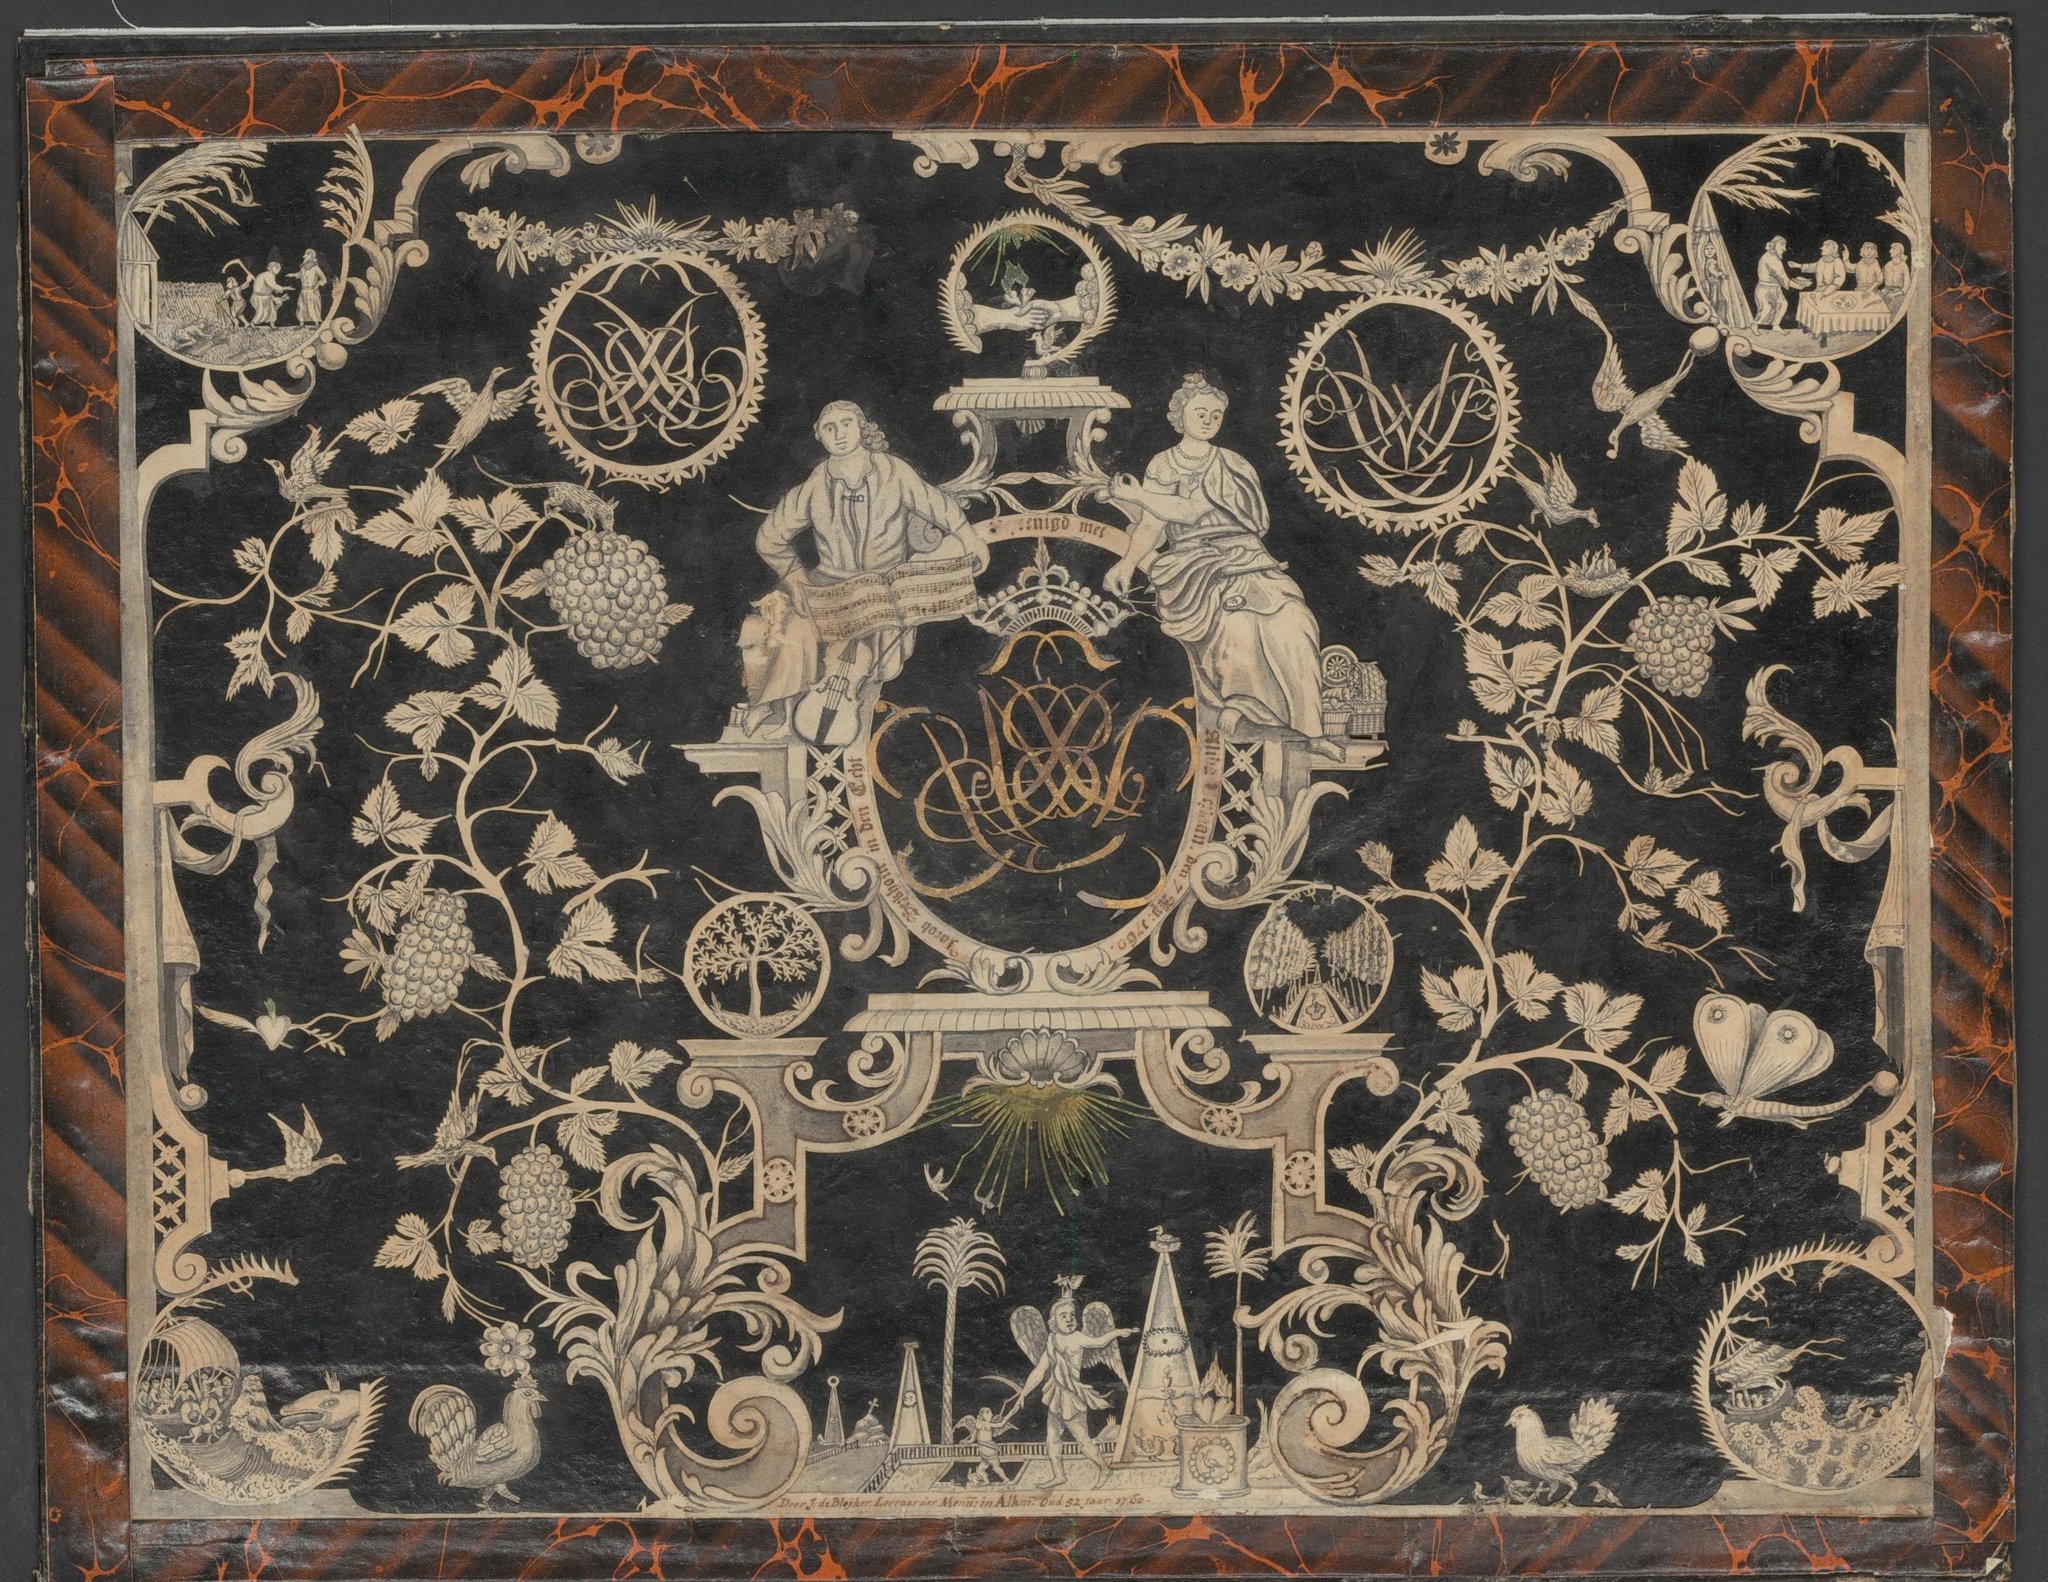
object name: cut paper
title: Huwelijksknipsel voor Jacob Berckhout en Alida Verlaan, 7 april 1760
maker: jan de bleyker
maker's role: knipkunstenaar, predikant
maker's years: 1707-1783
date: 1760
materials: cardboard, ink, paper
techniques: brush, marbling, pen, snipping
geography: alkmaar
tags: flowers, marriage, married couple, 'matrimonium'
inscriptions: stamp, collector's mark: Lugt 1641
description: Huwelijksknipsel voor Jacob Berckhout en Alida Verlaan, 7 april 1760. In het midden een gekroond spiegelmonogram binnen een ovaal. Op het ovaal in inkt: Jacob Berkhout in den Echt vereenigd met Alida Verlaan den 7 Ap. 1760. Links op het ovaal gezeten is de bruidegom afgebeeld met een muziekboek op de knie en een strijkinstrument. Rechts zit de bruid met een spinnewiel, een mand en een wiegje met een baby. Aan weerszijden van het ovaal wijnranken met druiventrossen, vogels, een muis en insecten. In de hoeken medaillons met bijbelse voorstellingen. Aan de onderzijde symbolische voorstellingen met obelisken en de Tijd met een zandloper. Onderwerpsrubrieken binnen de Atlas Zeden en Gewoonten: Schoone kunsten, Knipkunst.